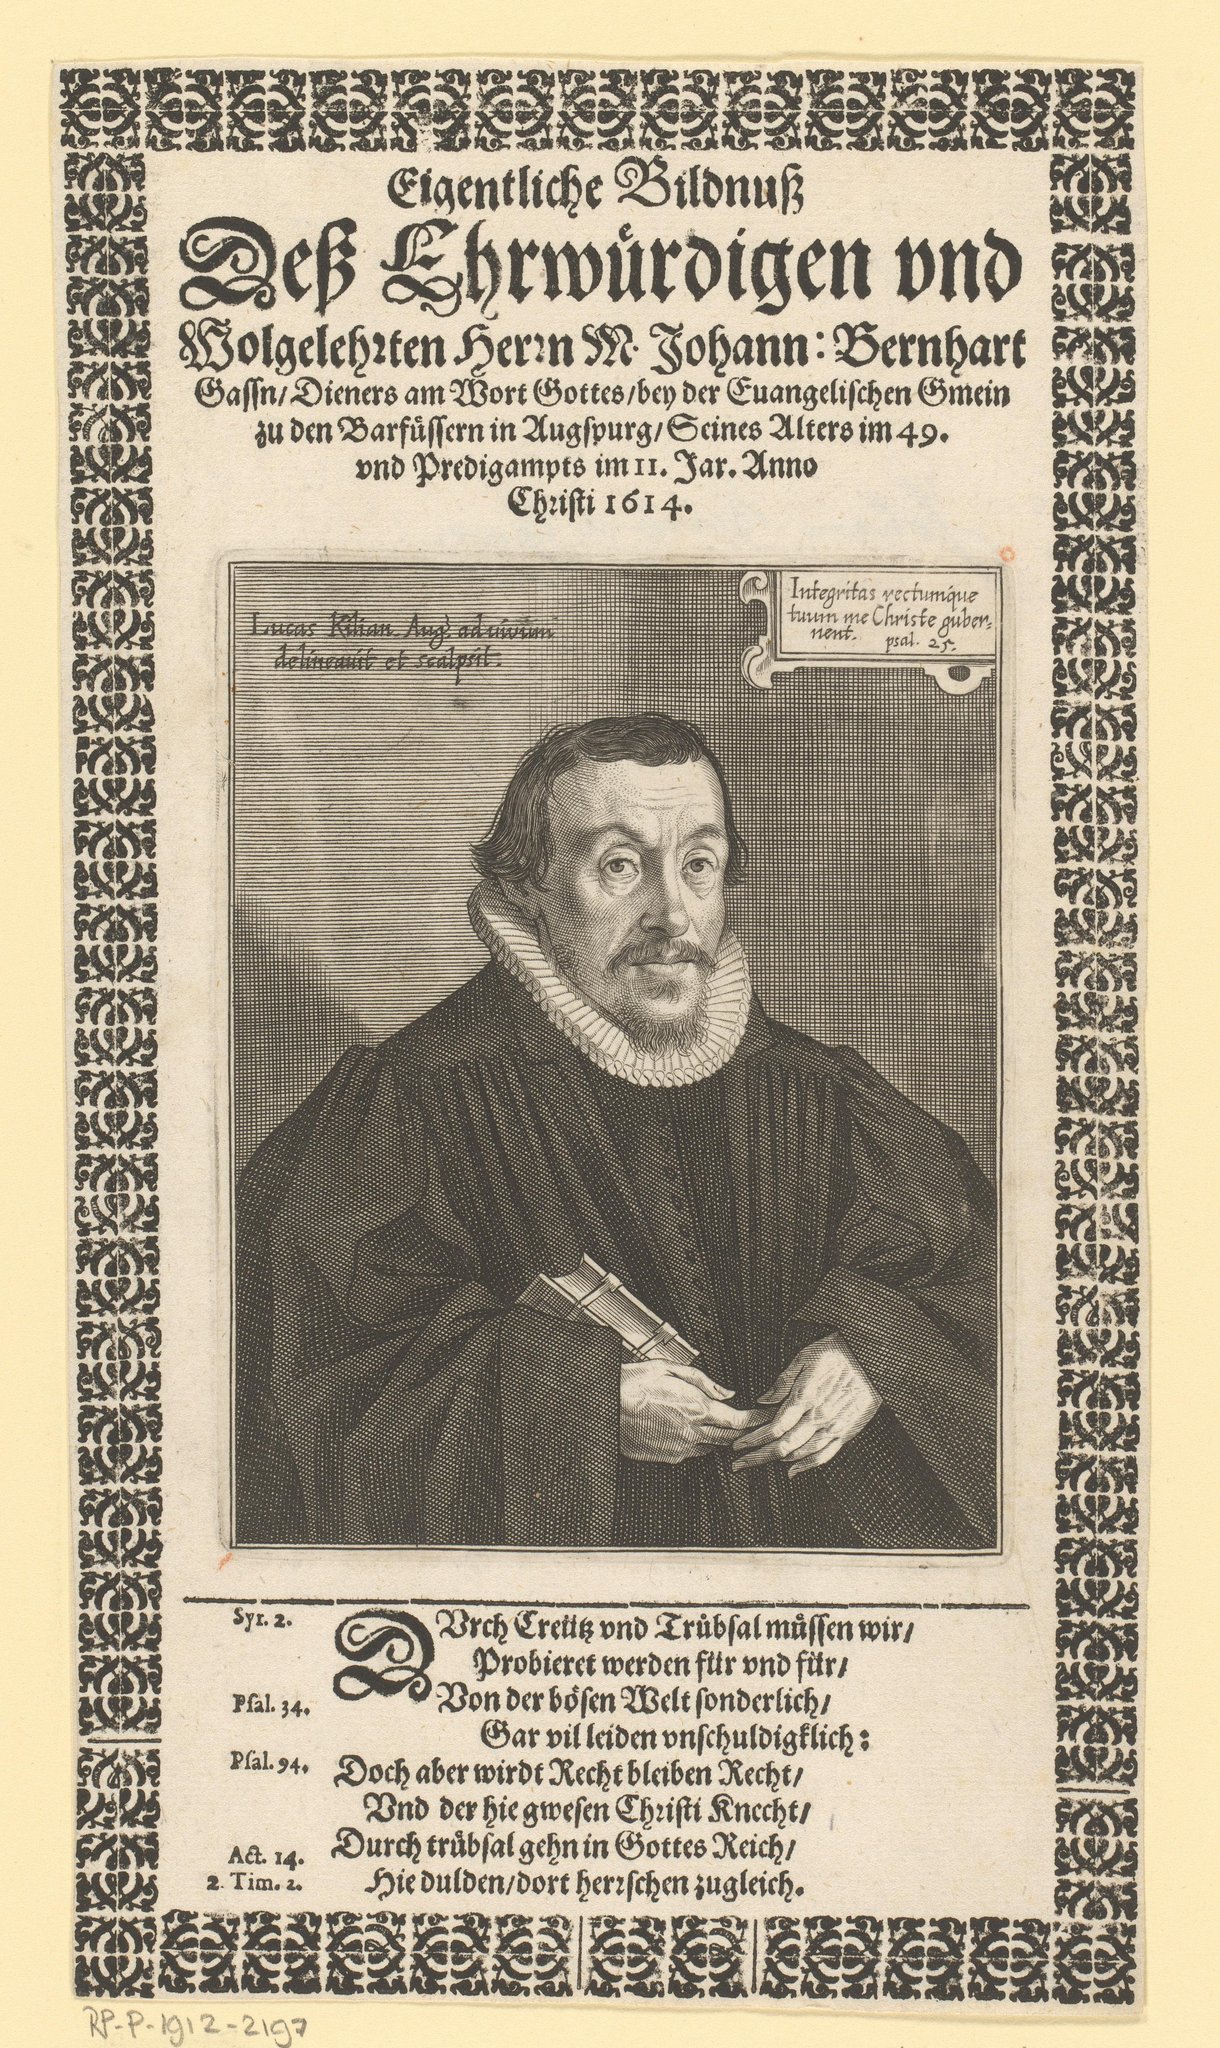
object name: print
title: Eigendliche Bildnuß deß Ehrwürdigen Wolgelehzten Herzn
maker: lucas kilian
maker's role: draughtsman, print maker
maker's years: 1579-1637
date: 1614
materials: paper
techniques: engraving, letterpress printing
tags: historical persons, book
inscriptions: collector's mark: Lugt 2228, watermark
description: Onder het portret diverse Bijbelcitaten.